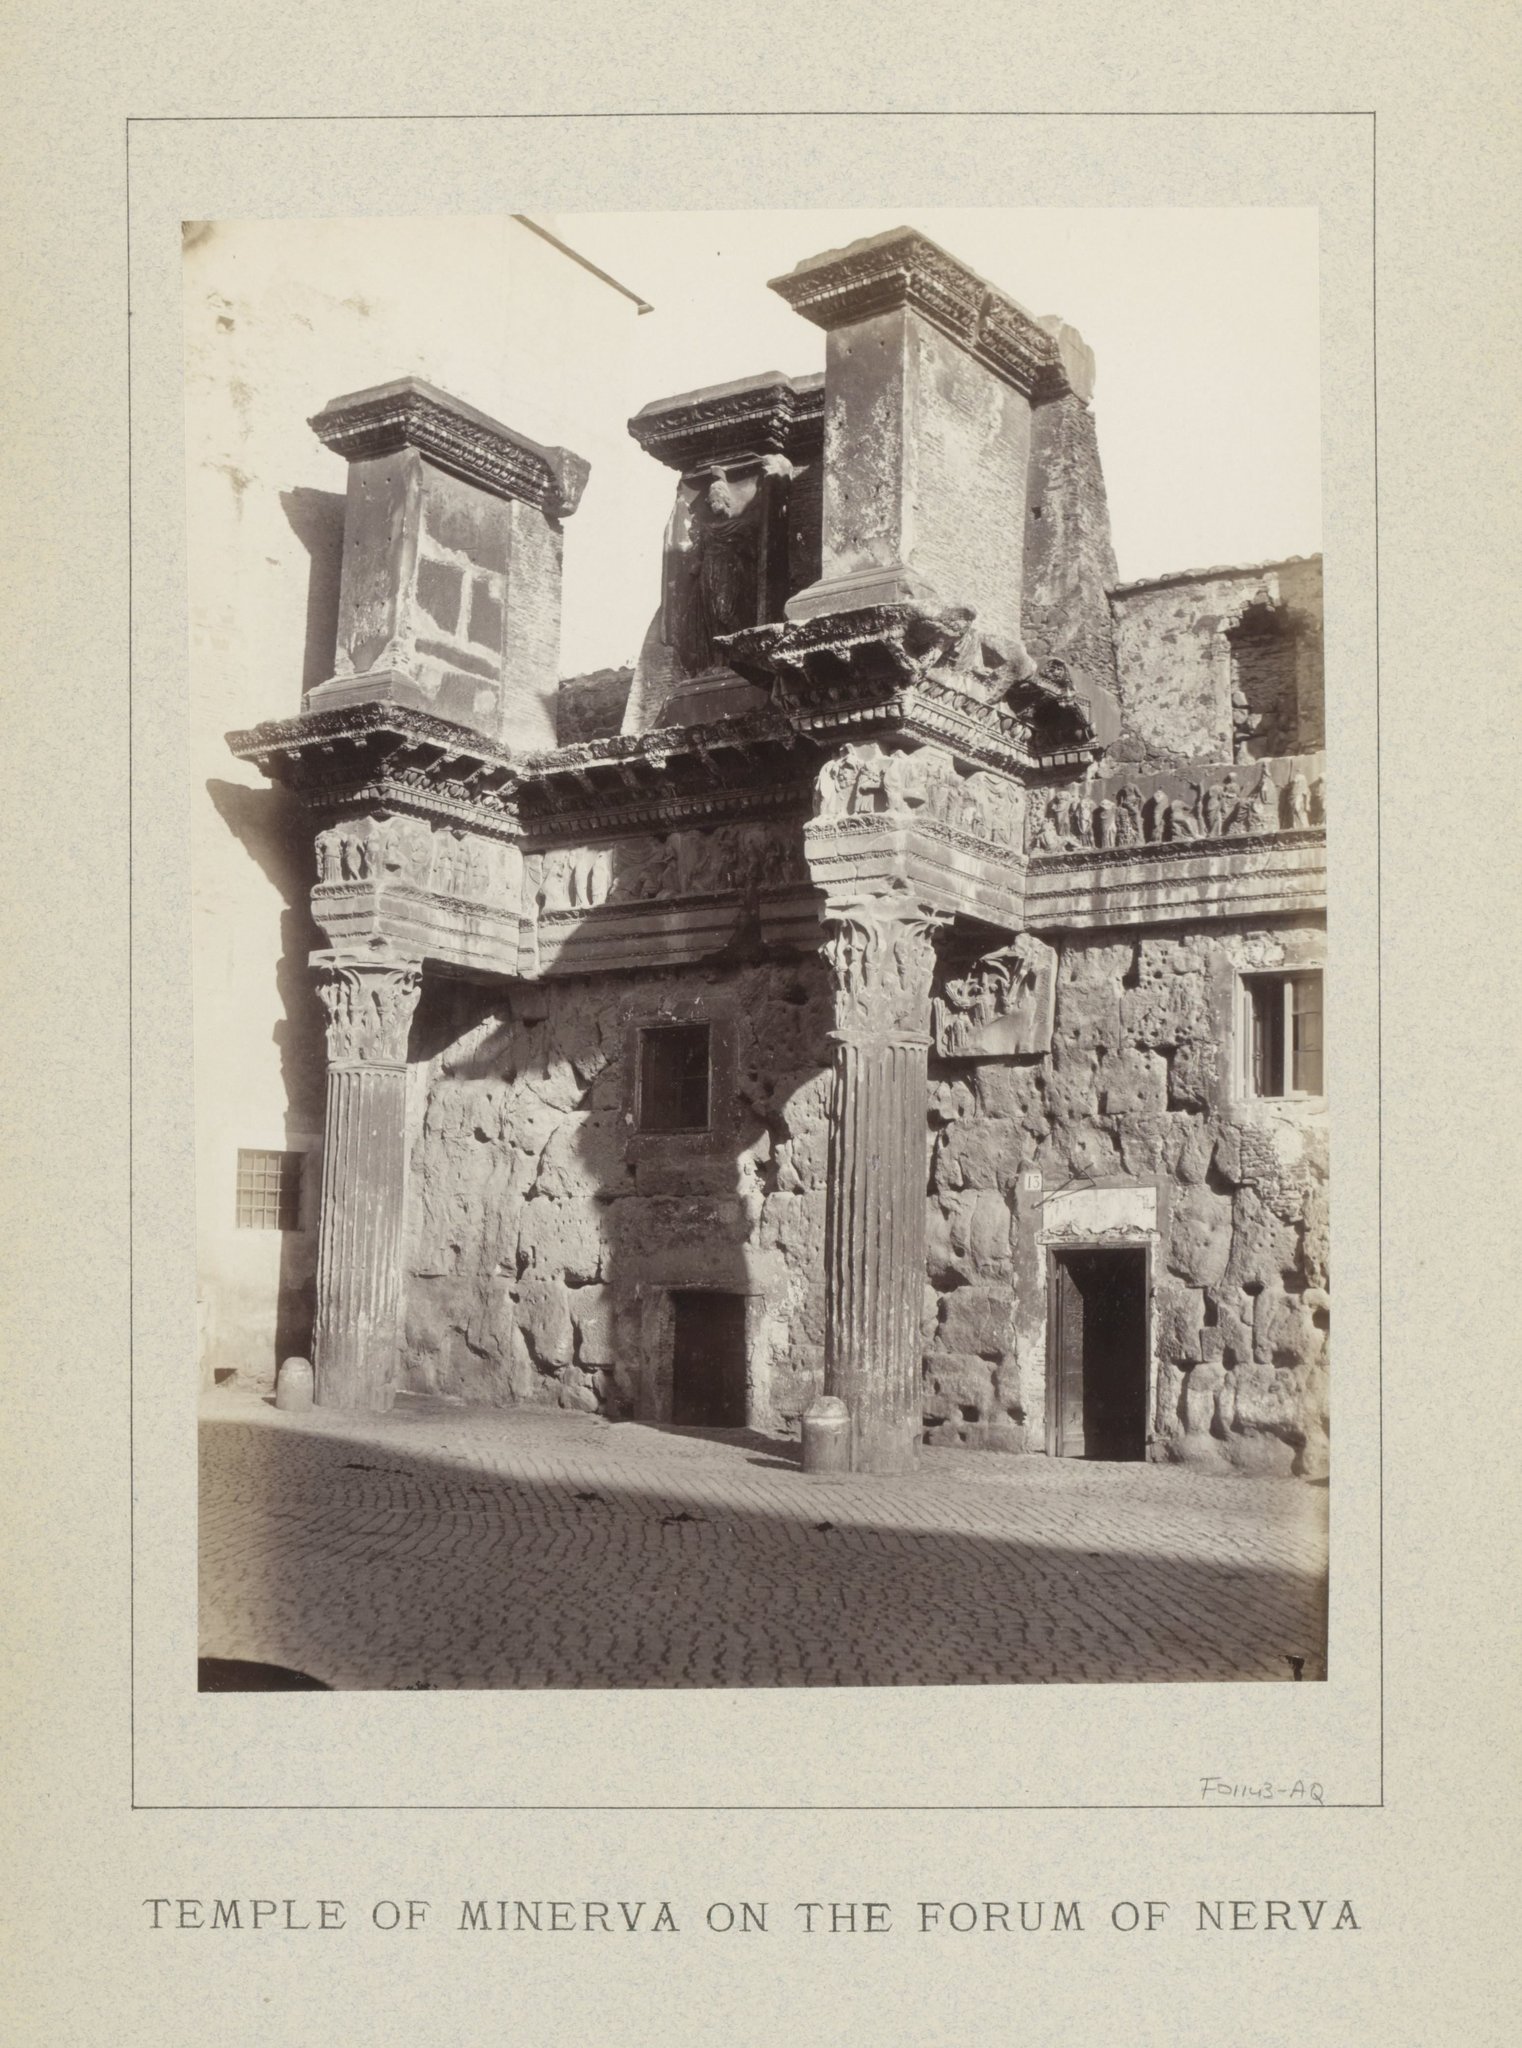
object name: photograph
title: Temple of Minerva on the Forum of Nerva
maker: Anonymous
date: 1860-1900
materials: photographic support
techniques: albumen print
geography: rome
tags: (story of) minerva (pallas, athena)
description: Onderdeel van Fotoalbum met opnames van bezienswaardigheden en kunstwerken in Rome.